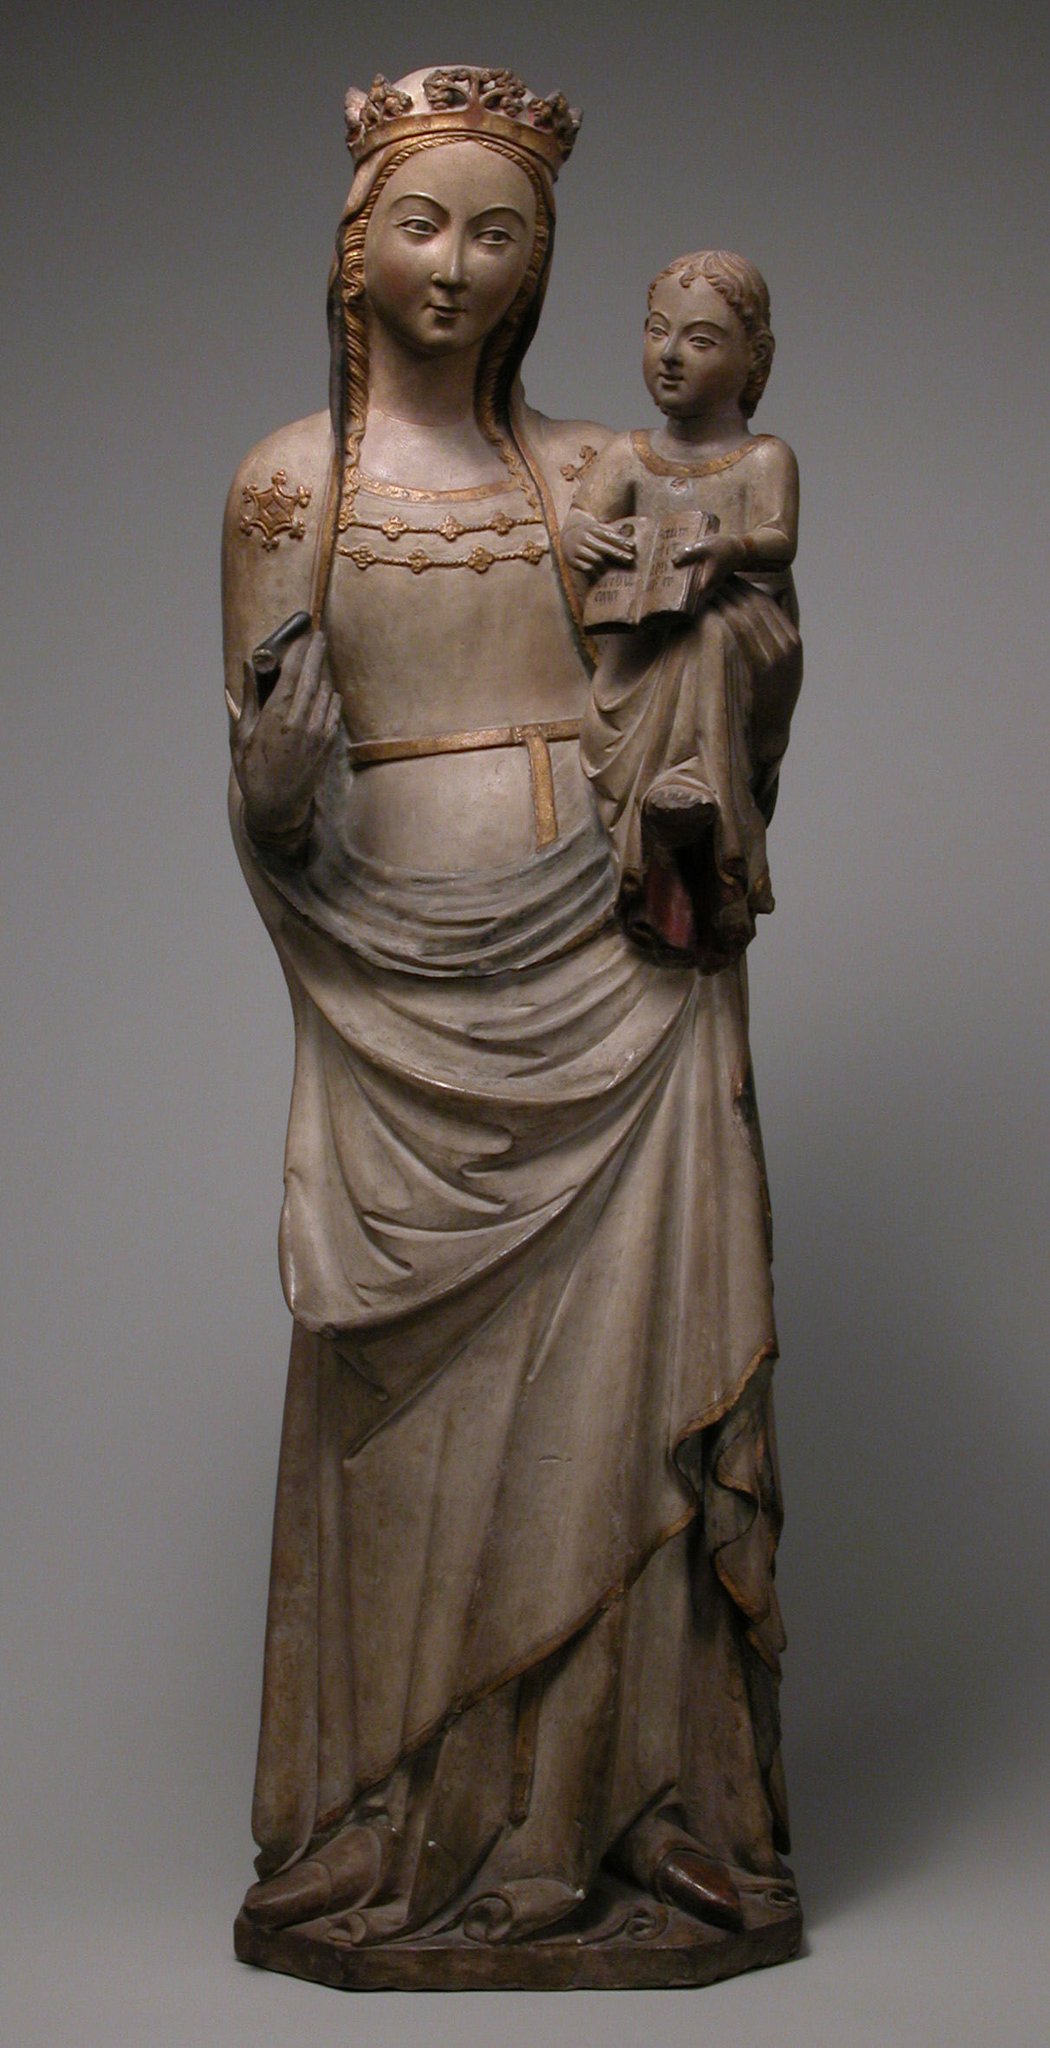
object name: statue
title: Virgin and Child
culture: catalan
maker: guillem seguer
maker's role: artist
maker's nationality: catalan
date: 1326-1350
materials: limestone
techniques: gilding, polychromy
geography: spain